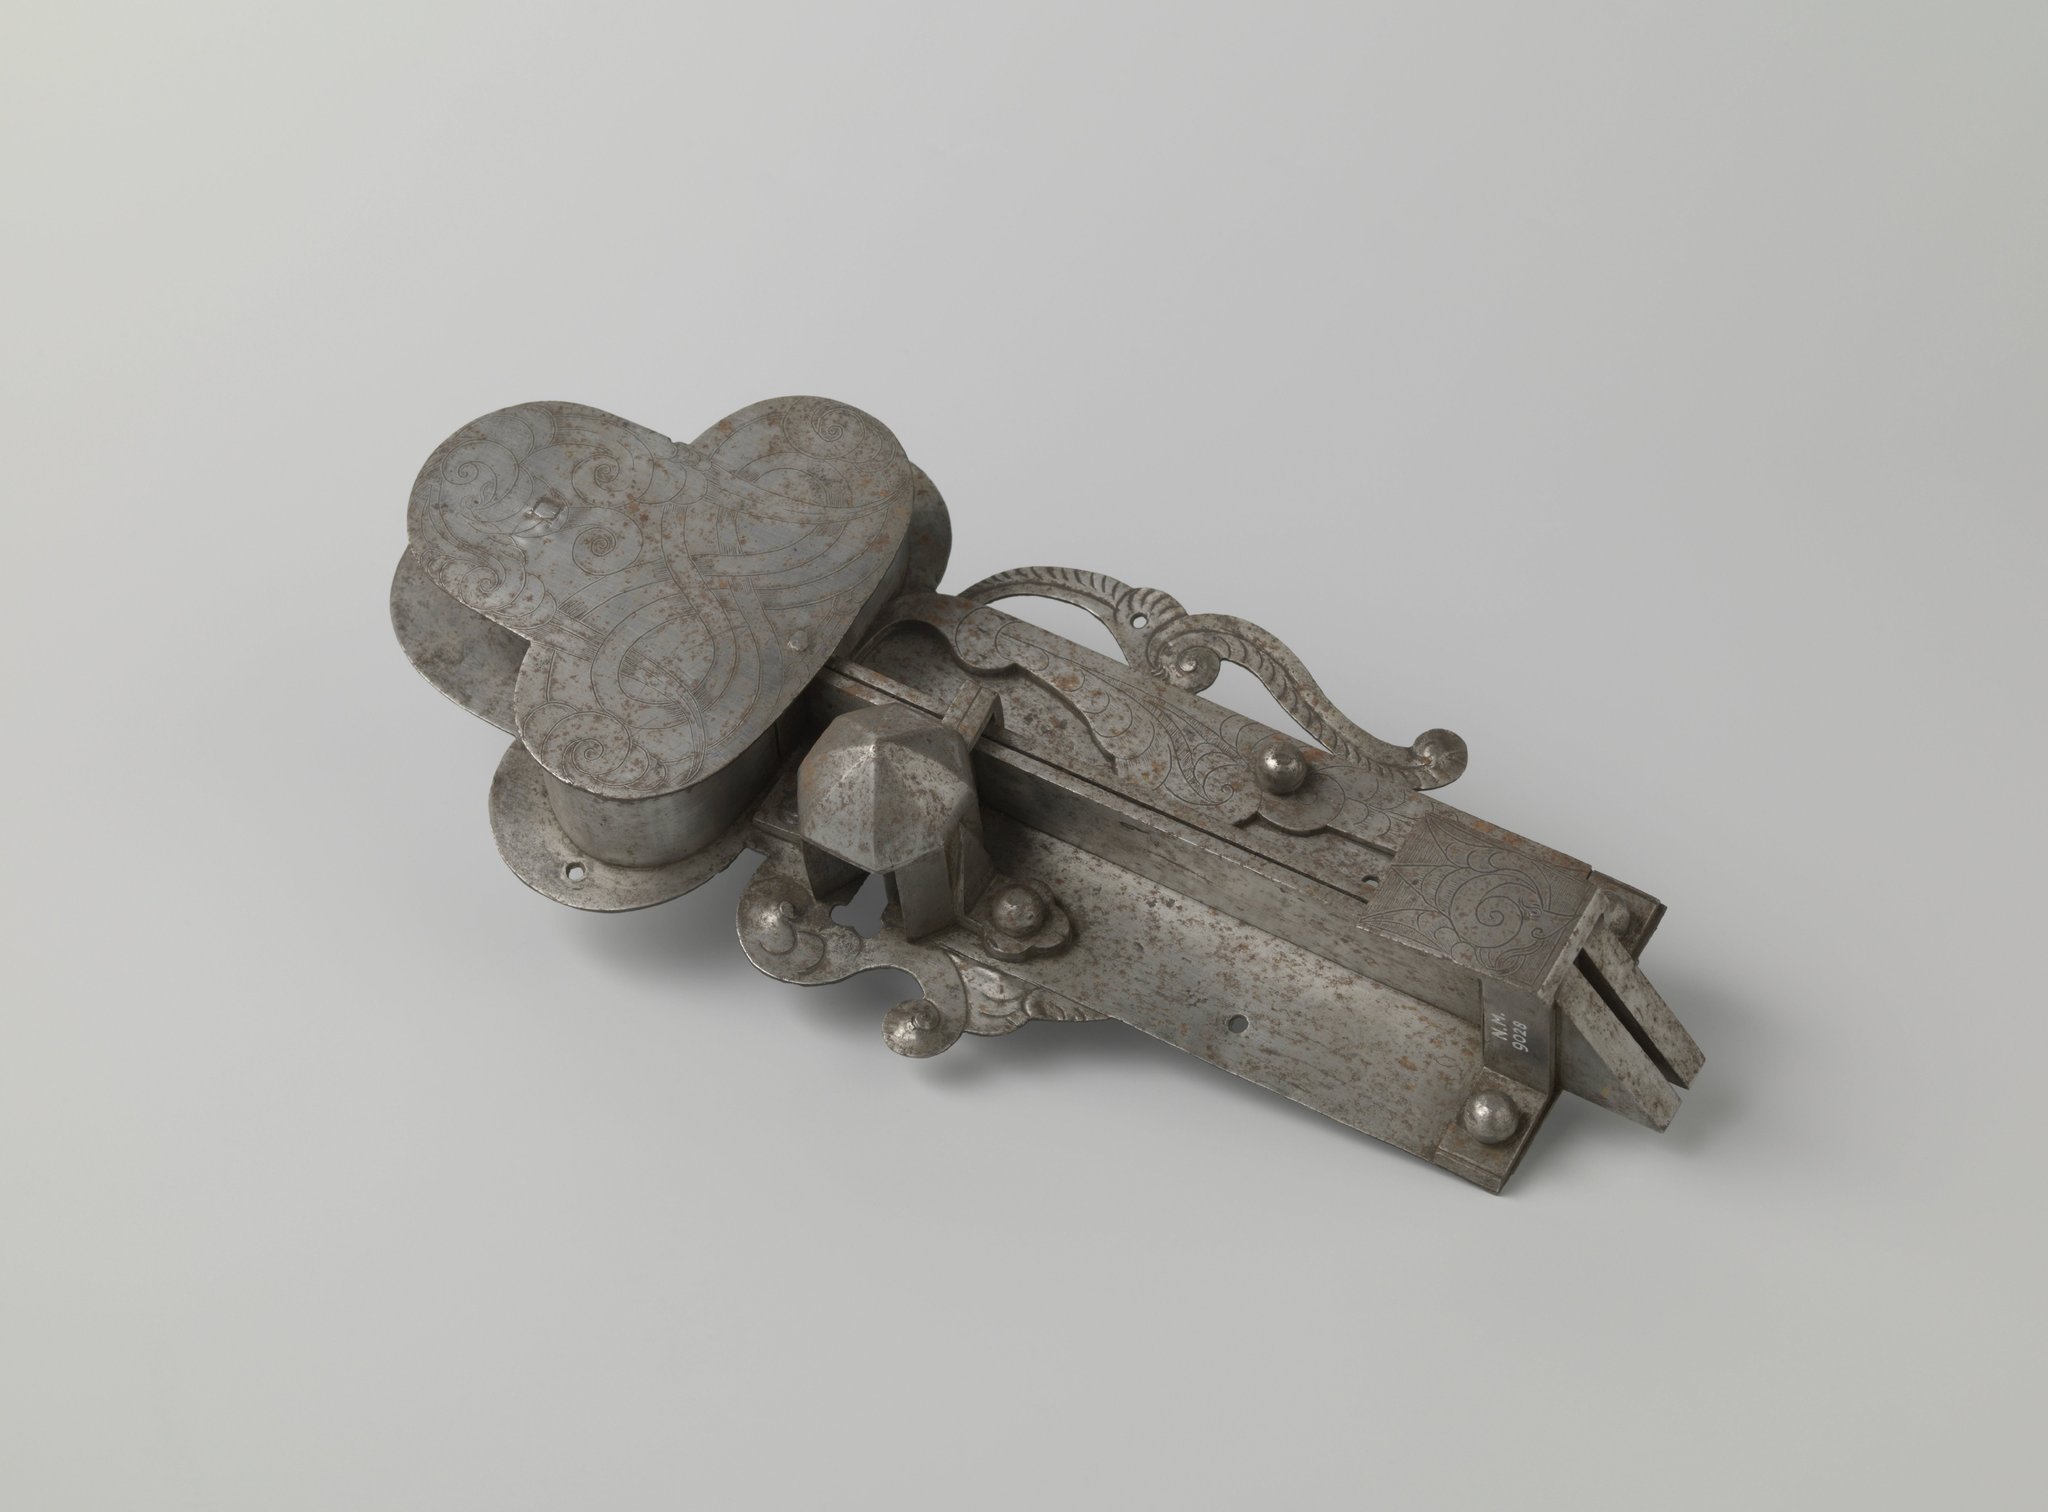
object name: lock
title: Slot met klavervormig dekblad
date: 1400-1950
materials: iron